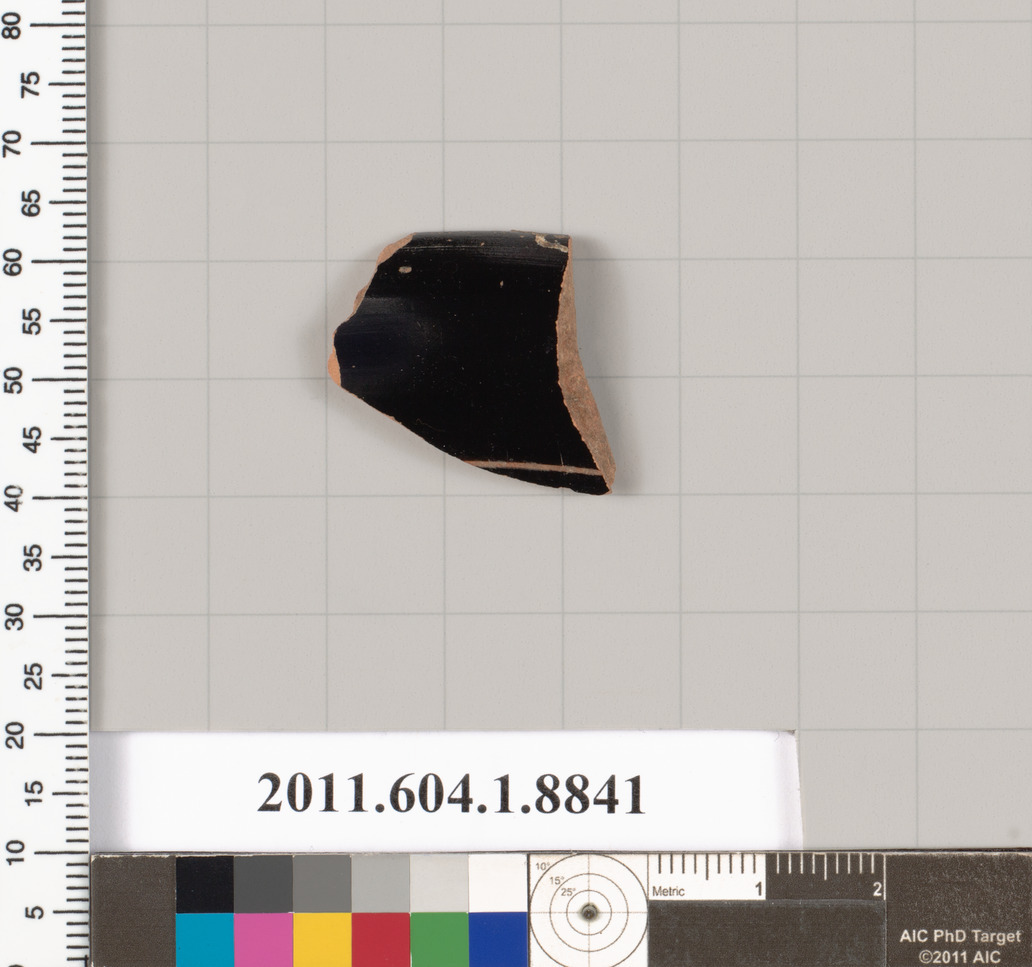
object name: kylix fragment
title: Terracotta rim fragment of a kylix (drinking cup)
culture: greek, attic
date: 500-470 BCE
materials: terracotta